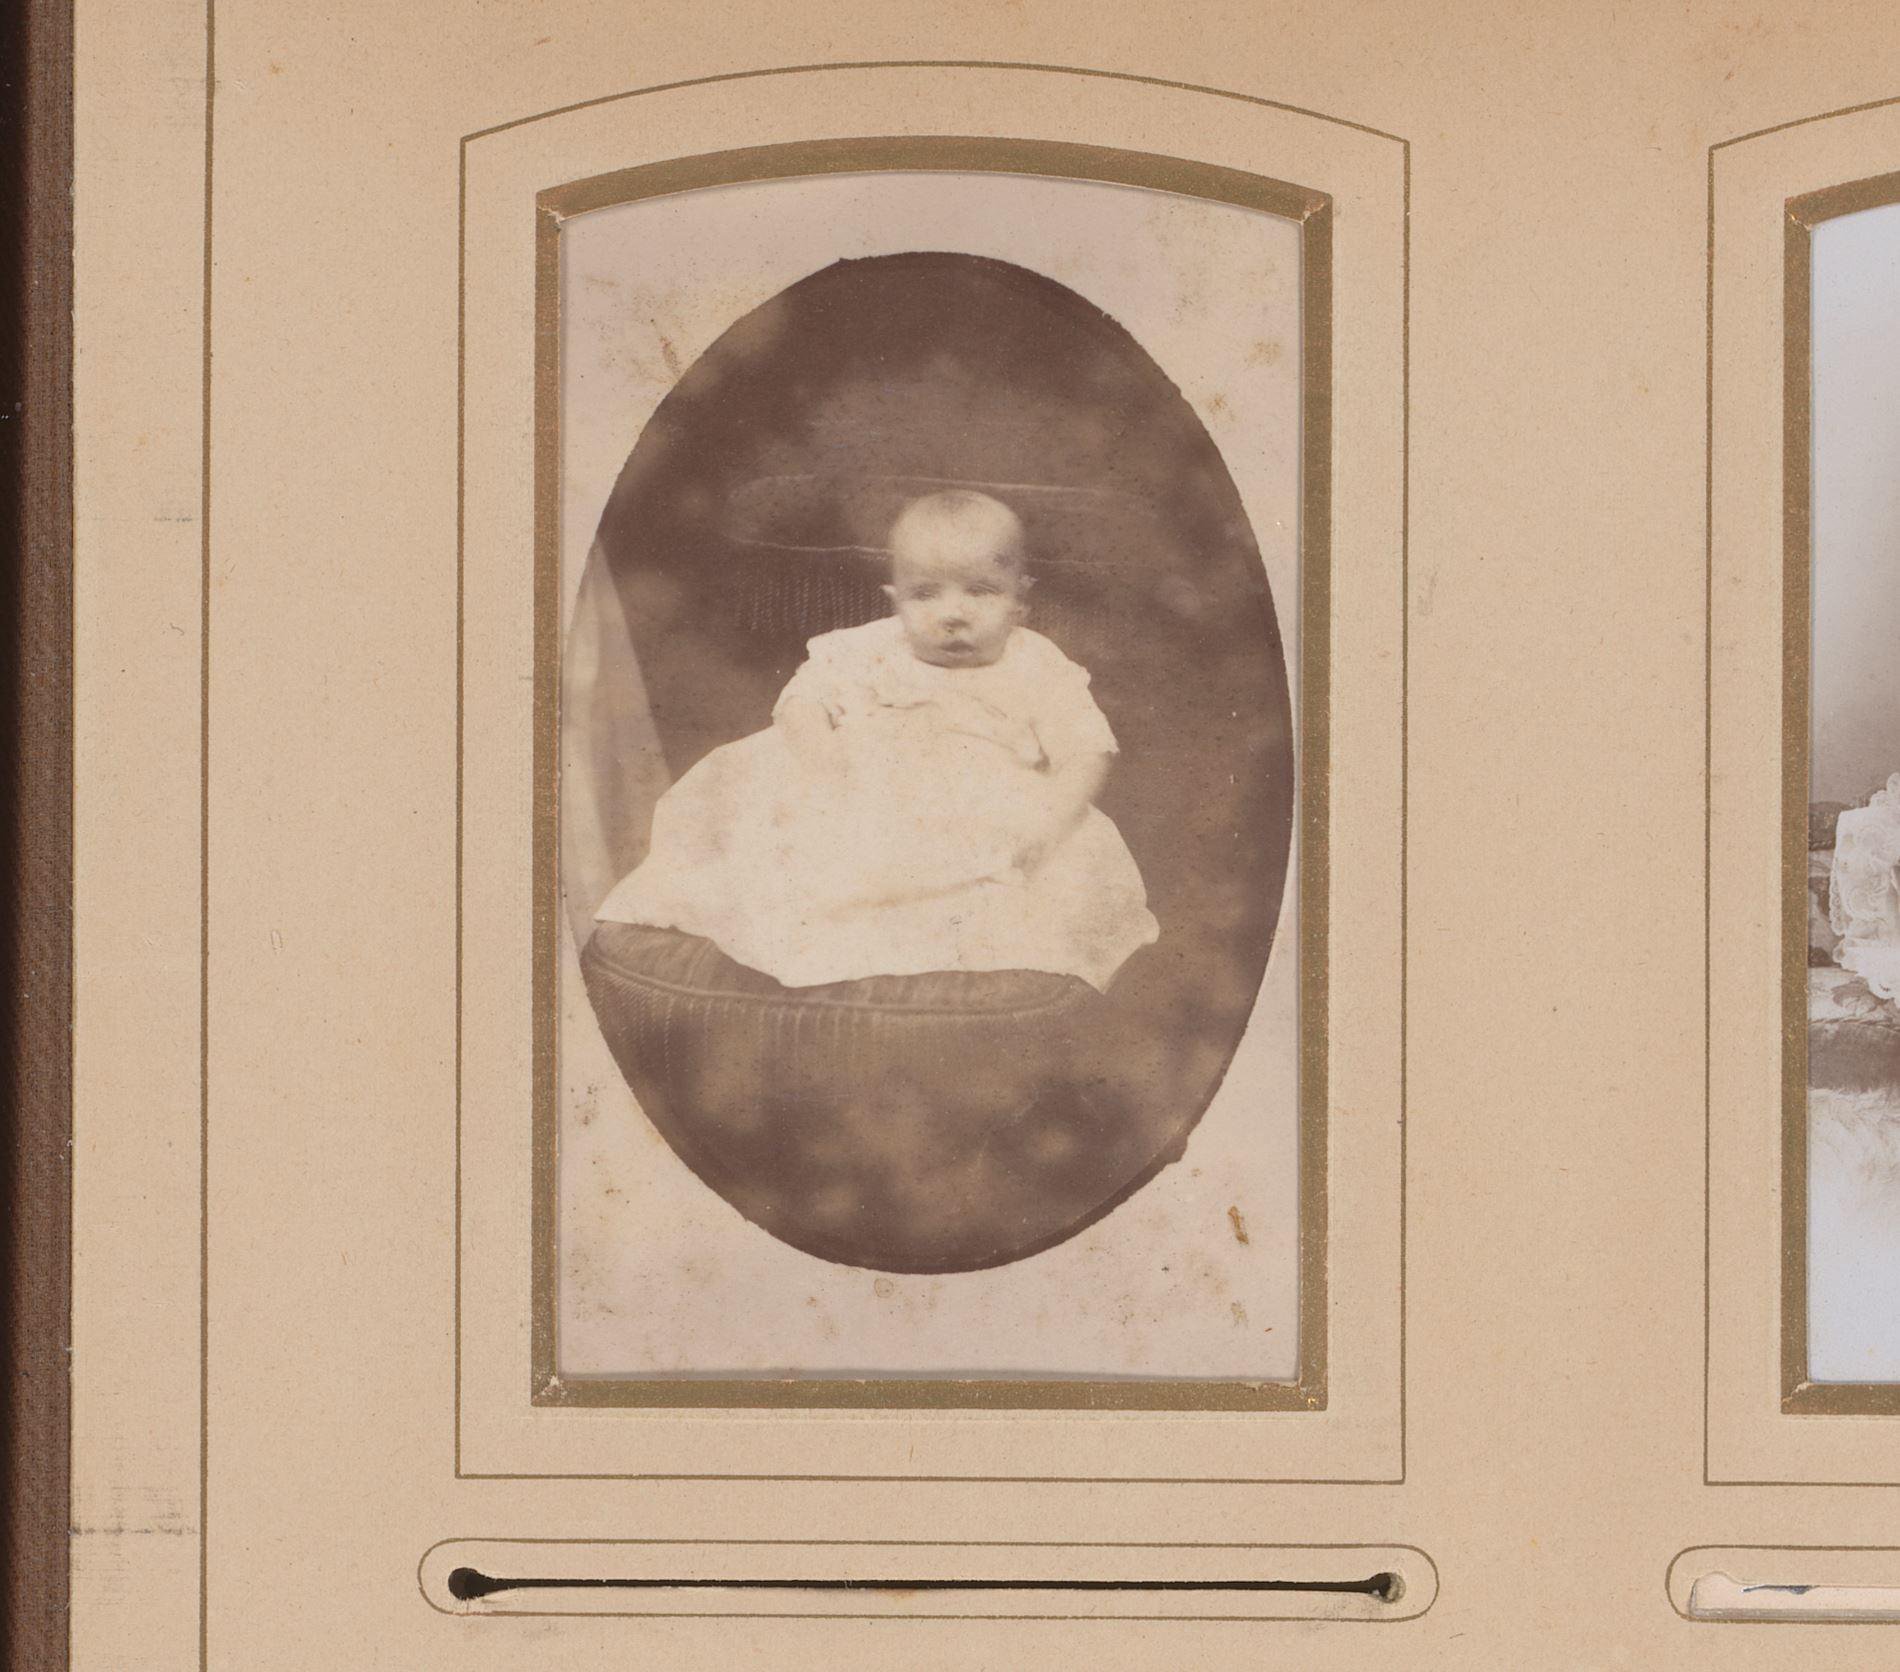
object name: semi enamel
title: Portret van een zittende baby, aangeduid als Wim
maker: hermanus jodocus weesing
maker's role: fotograaf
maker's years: 1844-1910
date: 1881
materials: cardboard, celluloid, photographic support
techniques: albumen print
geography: amsterdam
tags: sitting figure, historical persons, infant, baby ~ the ages of man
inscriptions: inscription: ‘Photographisch Atelier/ H.J. WEESING/ AMSTERDAM/ 5, Binnen Brouwerstraat 5./ Voor nabestelling worden de platen bewaard.’, annotation: ‘Wim x 1881/ half jaar’